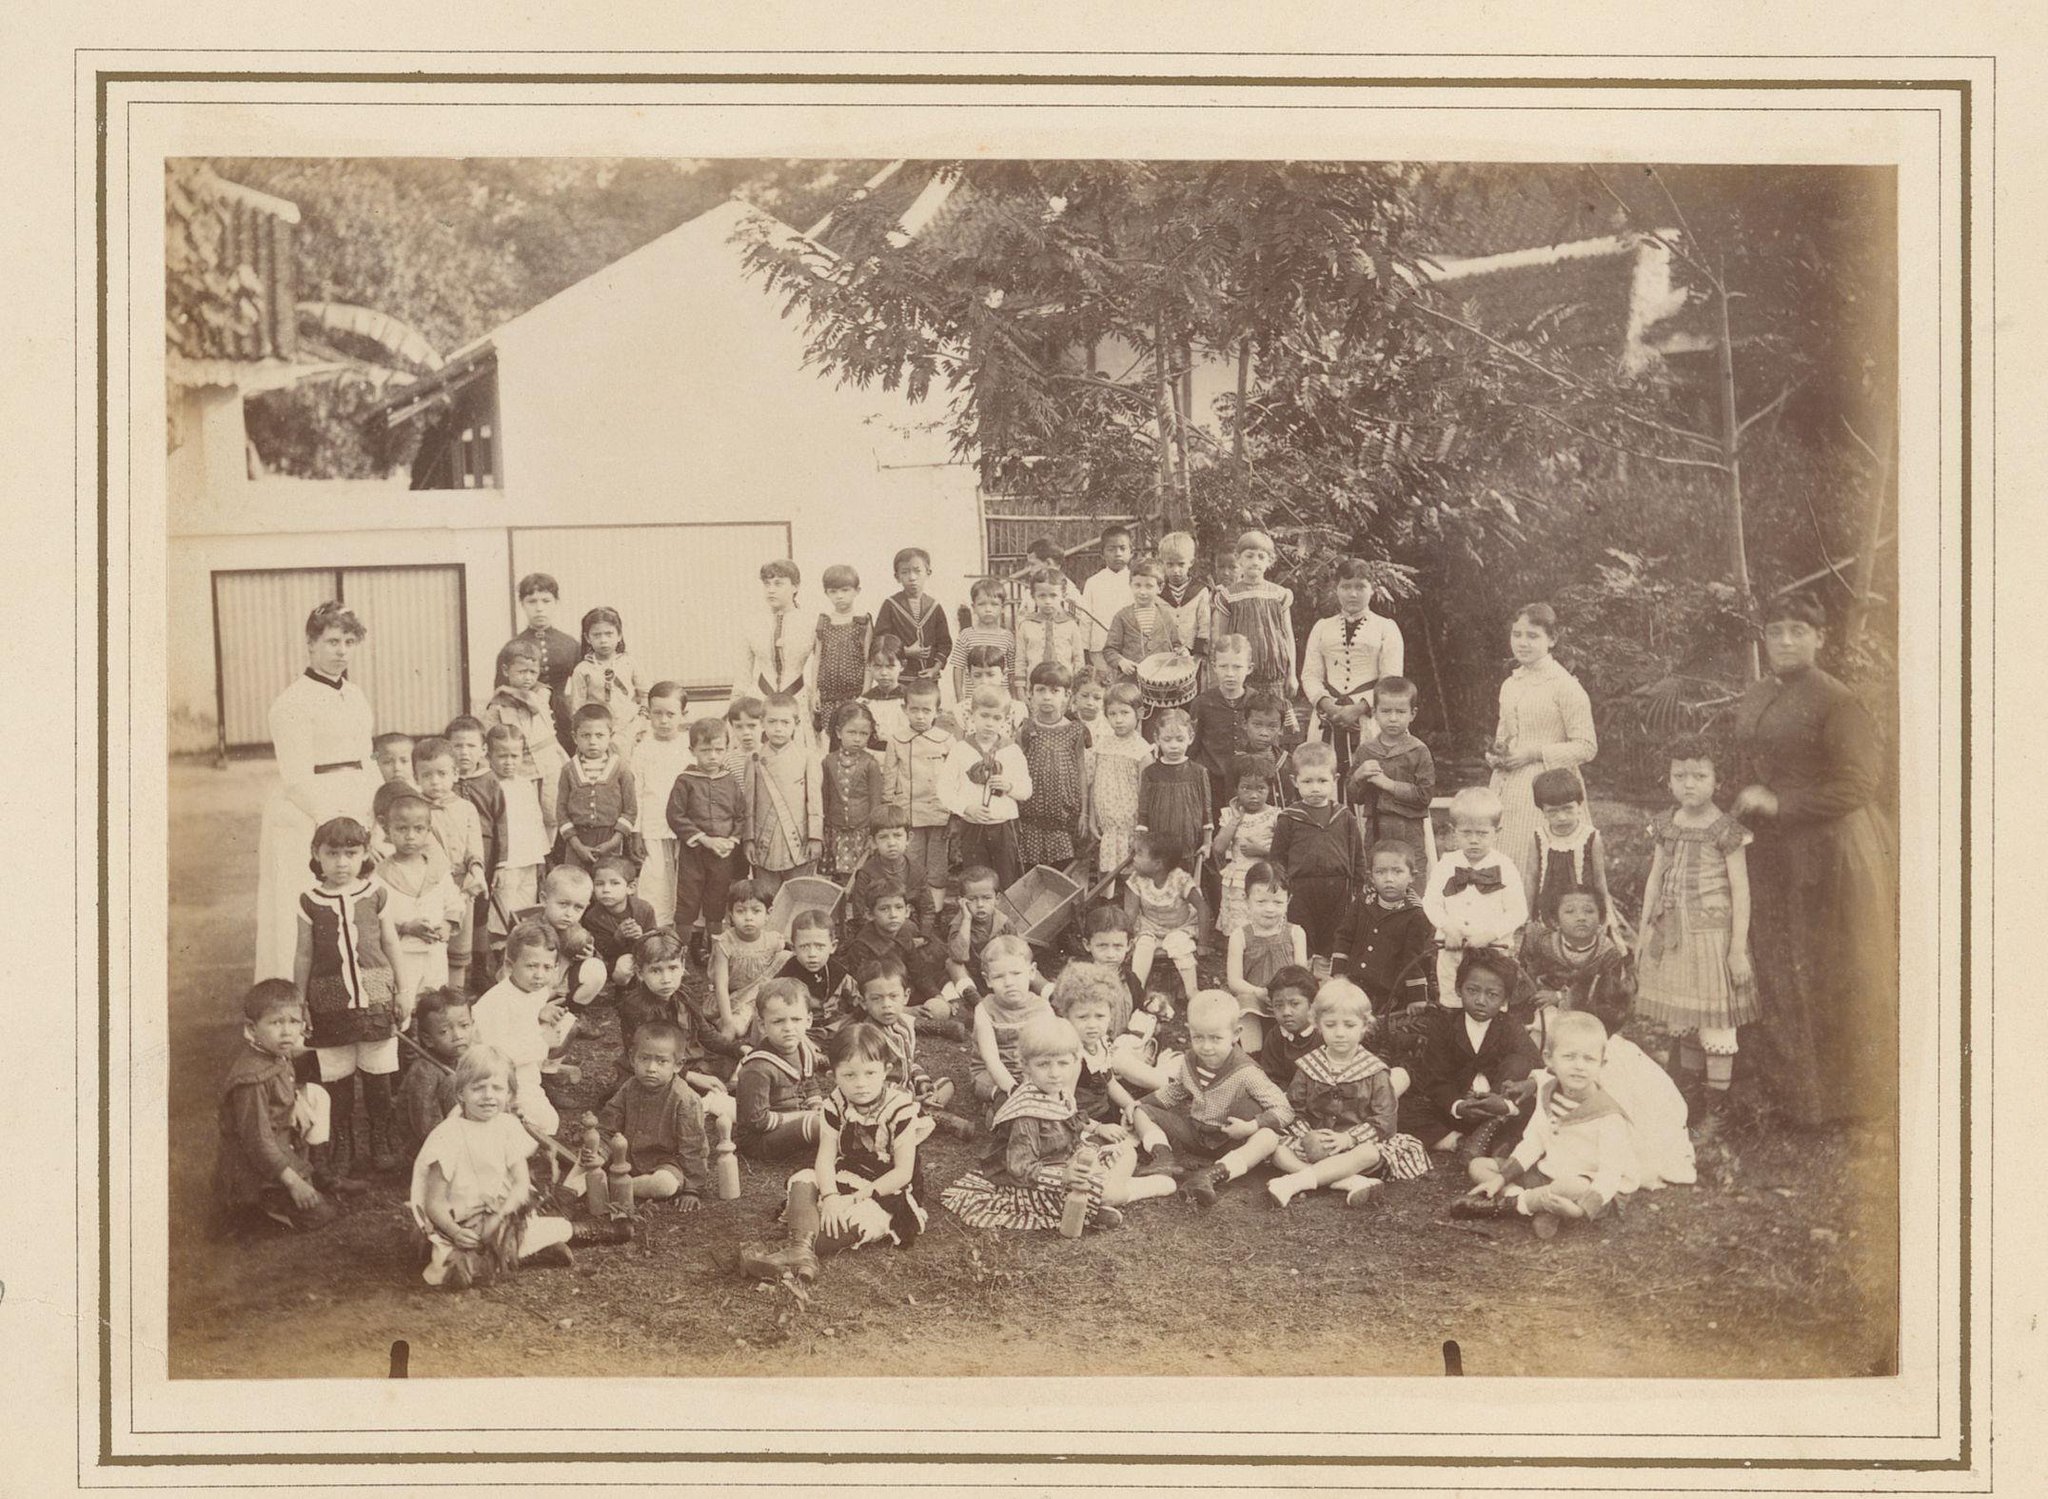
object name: photograph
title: Schoolklas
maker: kassian céphas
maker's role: fotograaf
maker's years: 1845-1912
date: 1886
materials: photographic support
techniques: albumen print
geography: jogjakarta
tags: elementary school; class, form (+ pupil)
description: Groepsfoto van een klas van Europese kinderen met hun onderwijzeressen. Onderdeel van het fotoalbum aangeboden aan J.M. Pijnacker Hordijk bij zijn vertrek uit Jogyakarta in 1886.